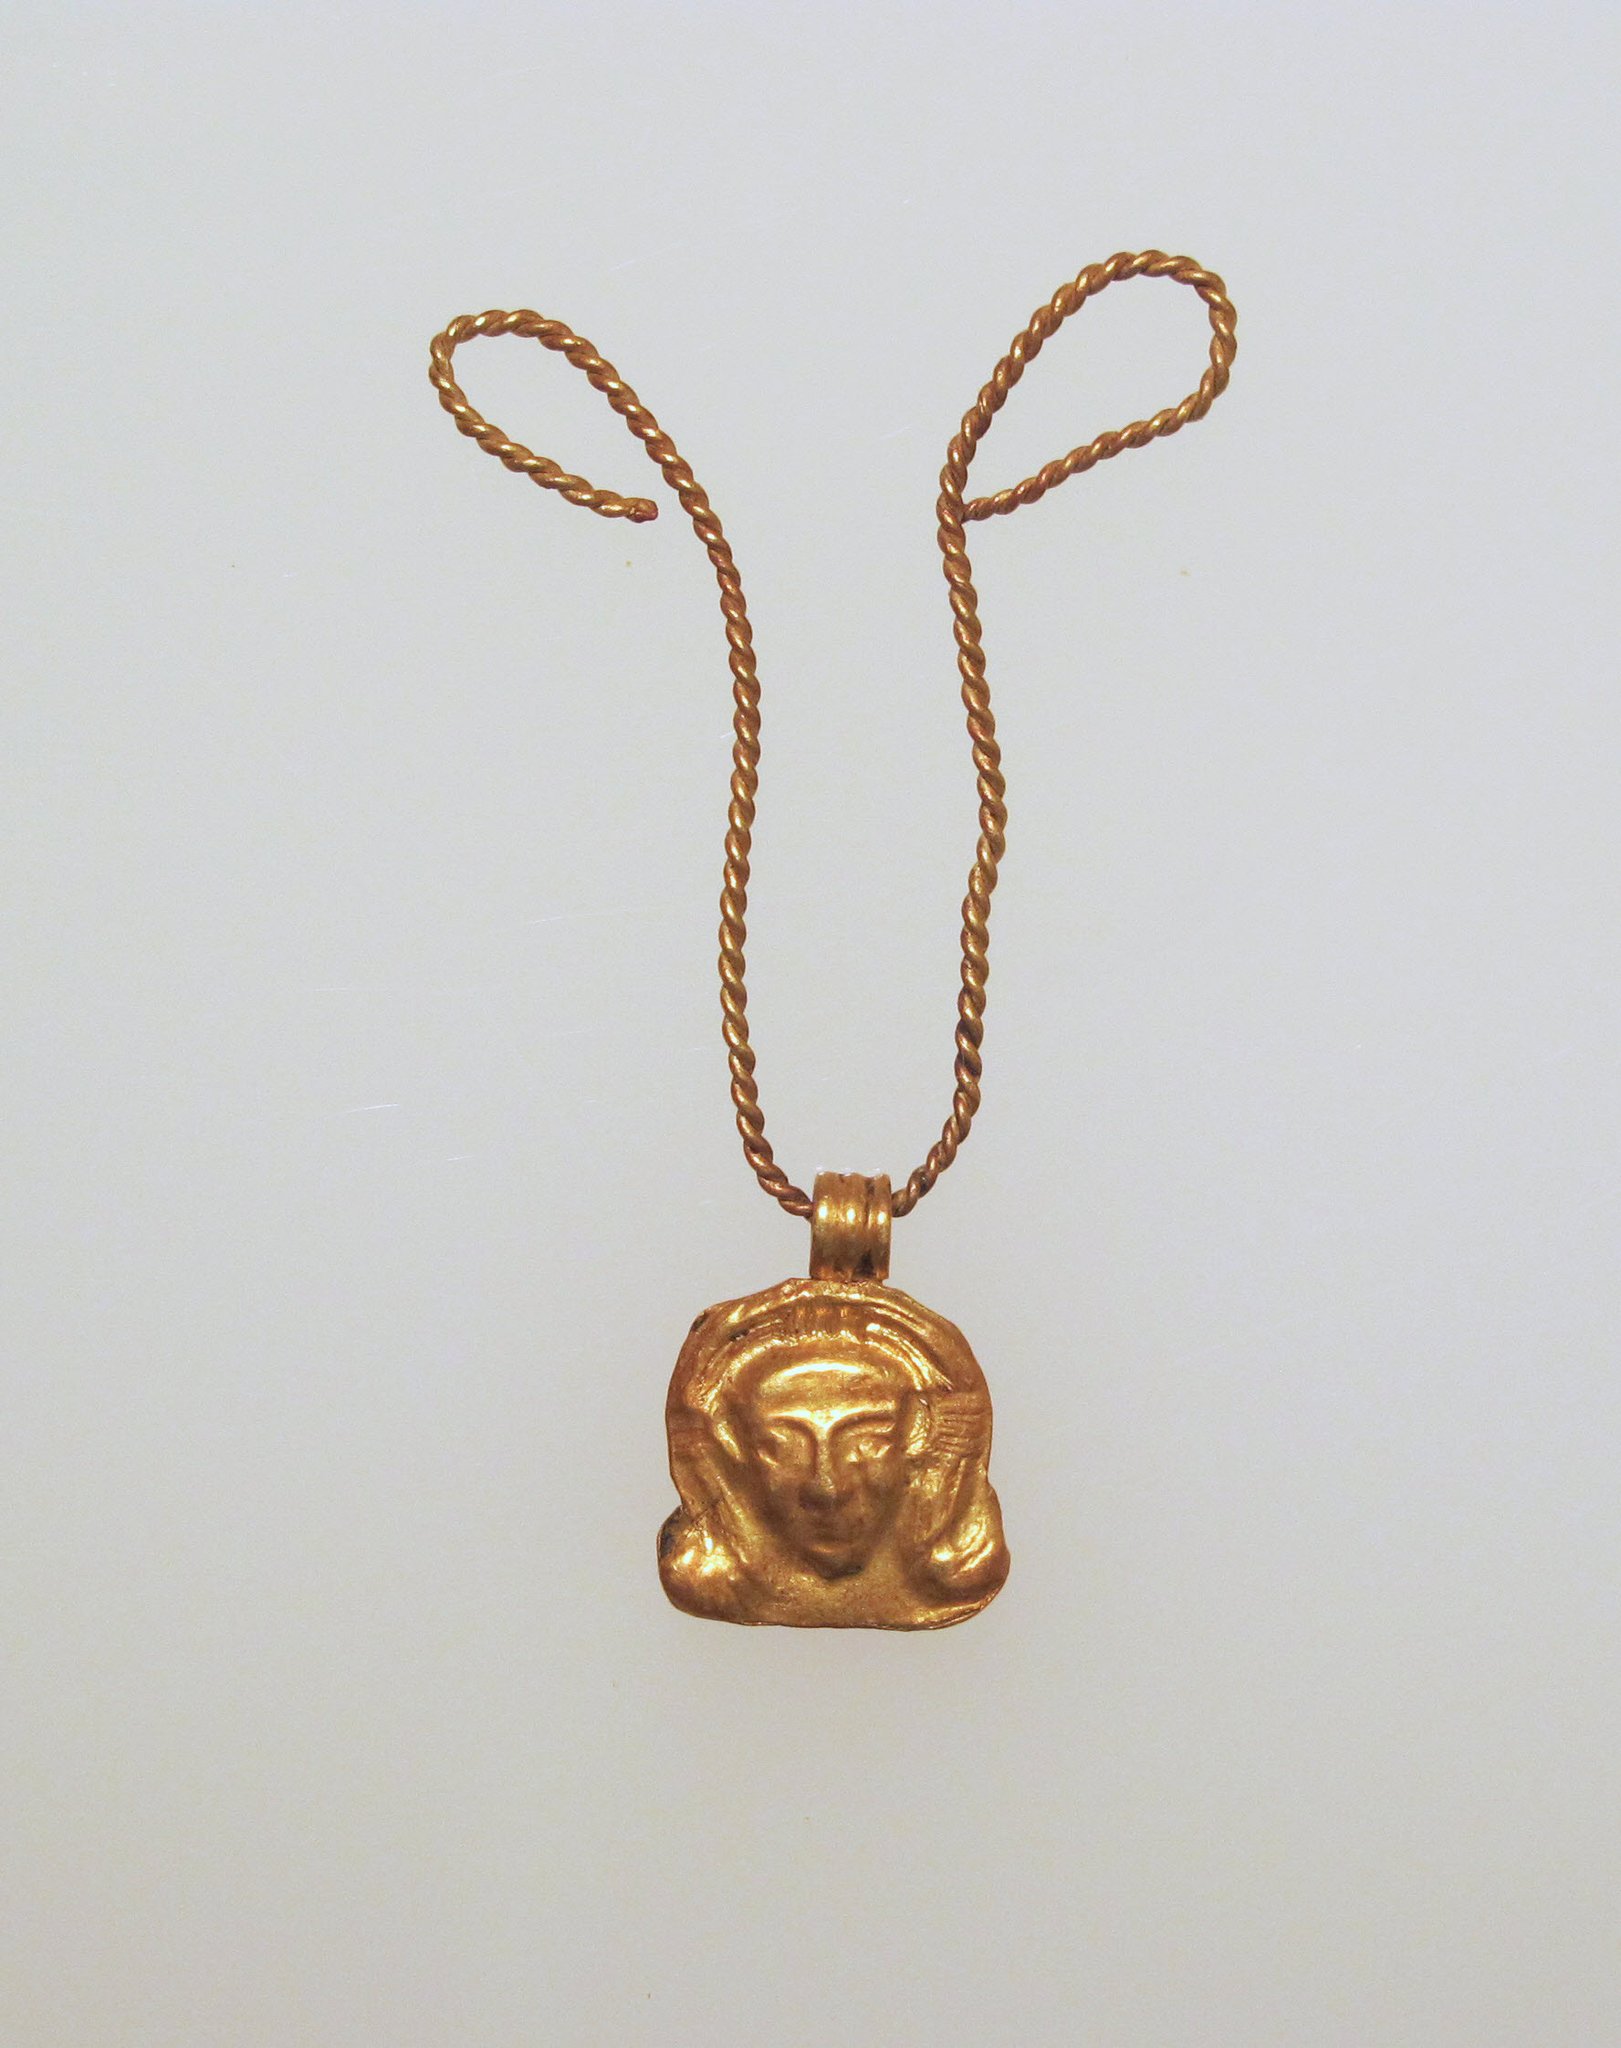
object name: pendant in the form of hathor's head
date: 7000 BCE-330 CE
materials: gold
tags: hathor